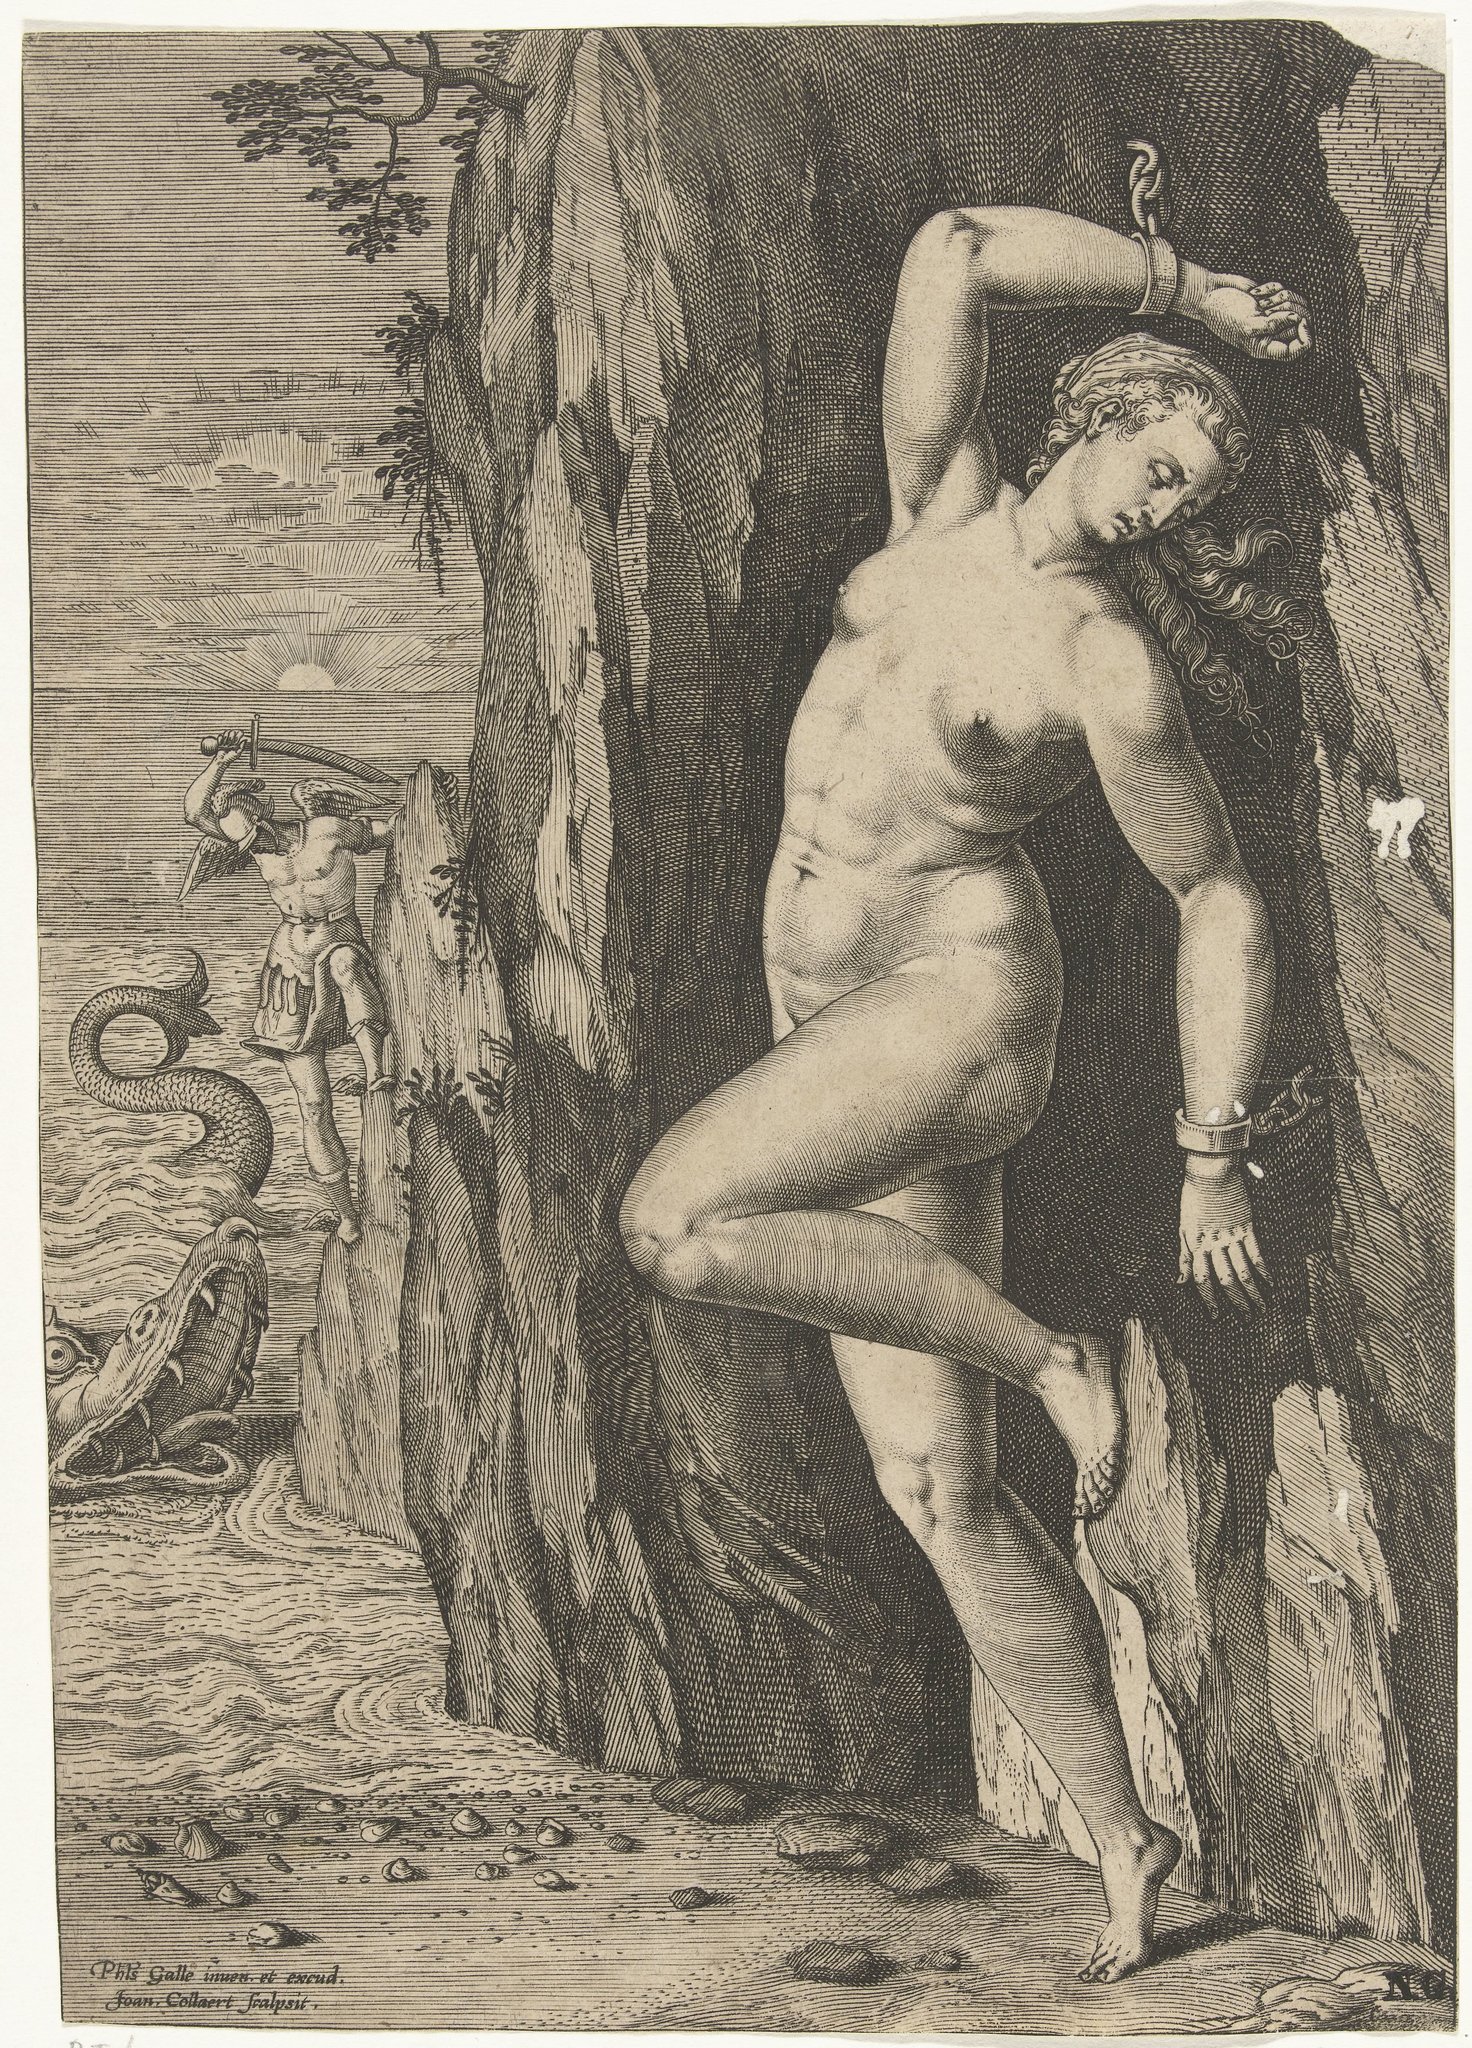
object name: print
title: Perseus en Andromeda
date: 1576-1628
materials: paper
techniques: engraving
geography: antwerp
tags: perseus kills the sea monster (or turns it into stone by showing it the gorgon's head) to release andromeda; sometimes her parents cepheus and cassiopea watch the scene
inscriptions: collector's mark: Lugt 1967, collector's mark: Lugt 2228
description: Andromeda, de dochter van een Ethiopische koning, is vastgeketend aan een rots. Op de achtergrond verslaat Perseus het zeemonster om Andromeda te kunnen komen redden.